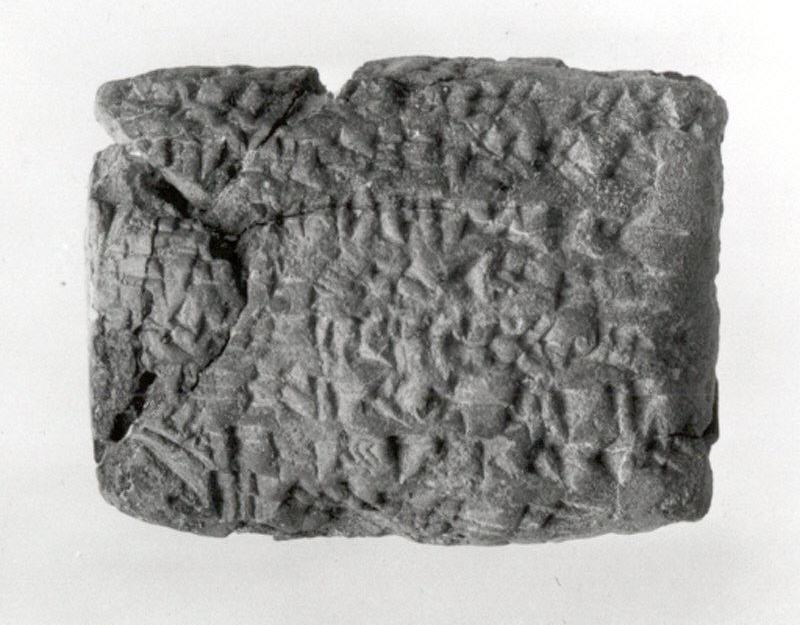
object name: cuneiform tablet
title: Cuneiform tablet: quittance, Esagilaya archive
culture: babylonian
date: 550 BCE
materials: clay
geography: mesopotamia